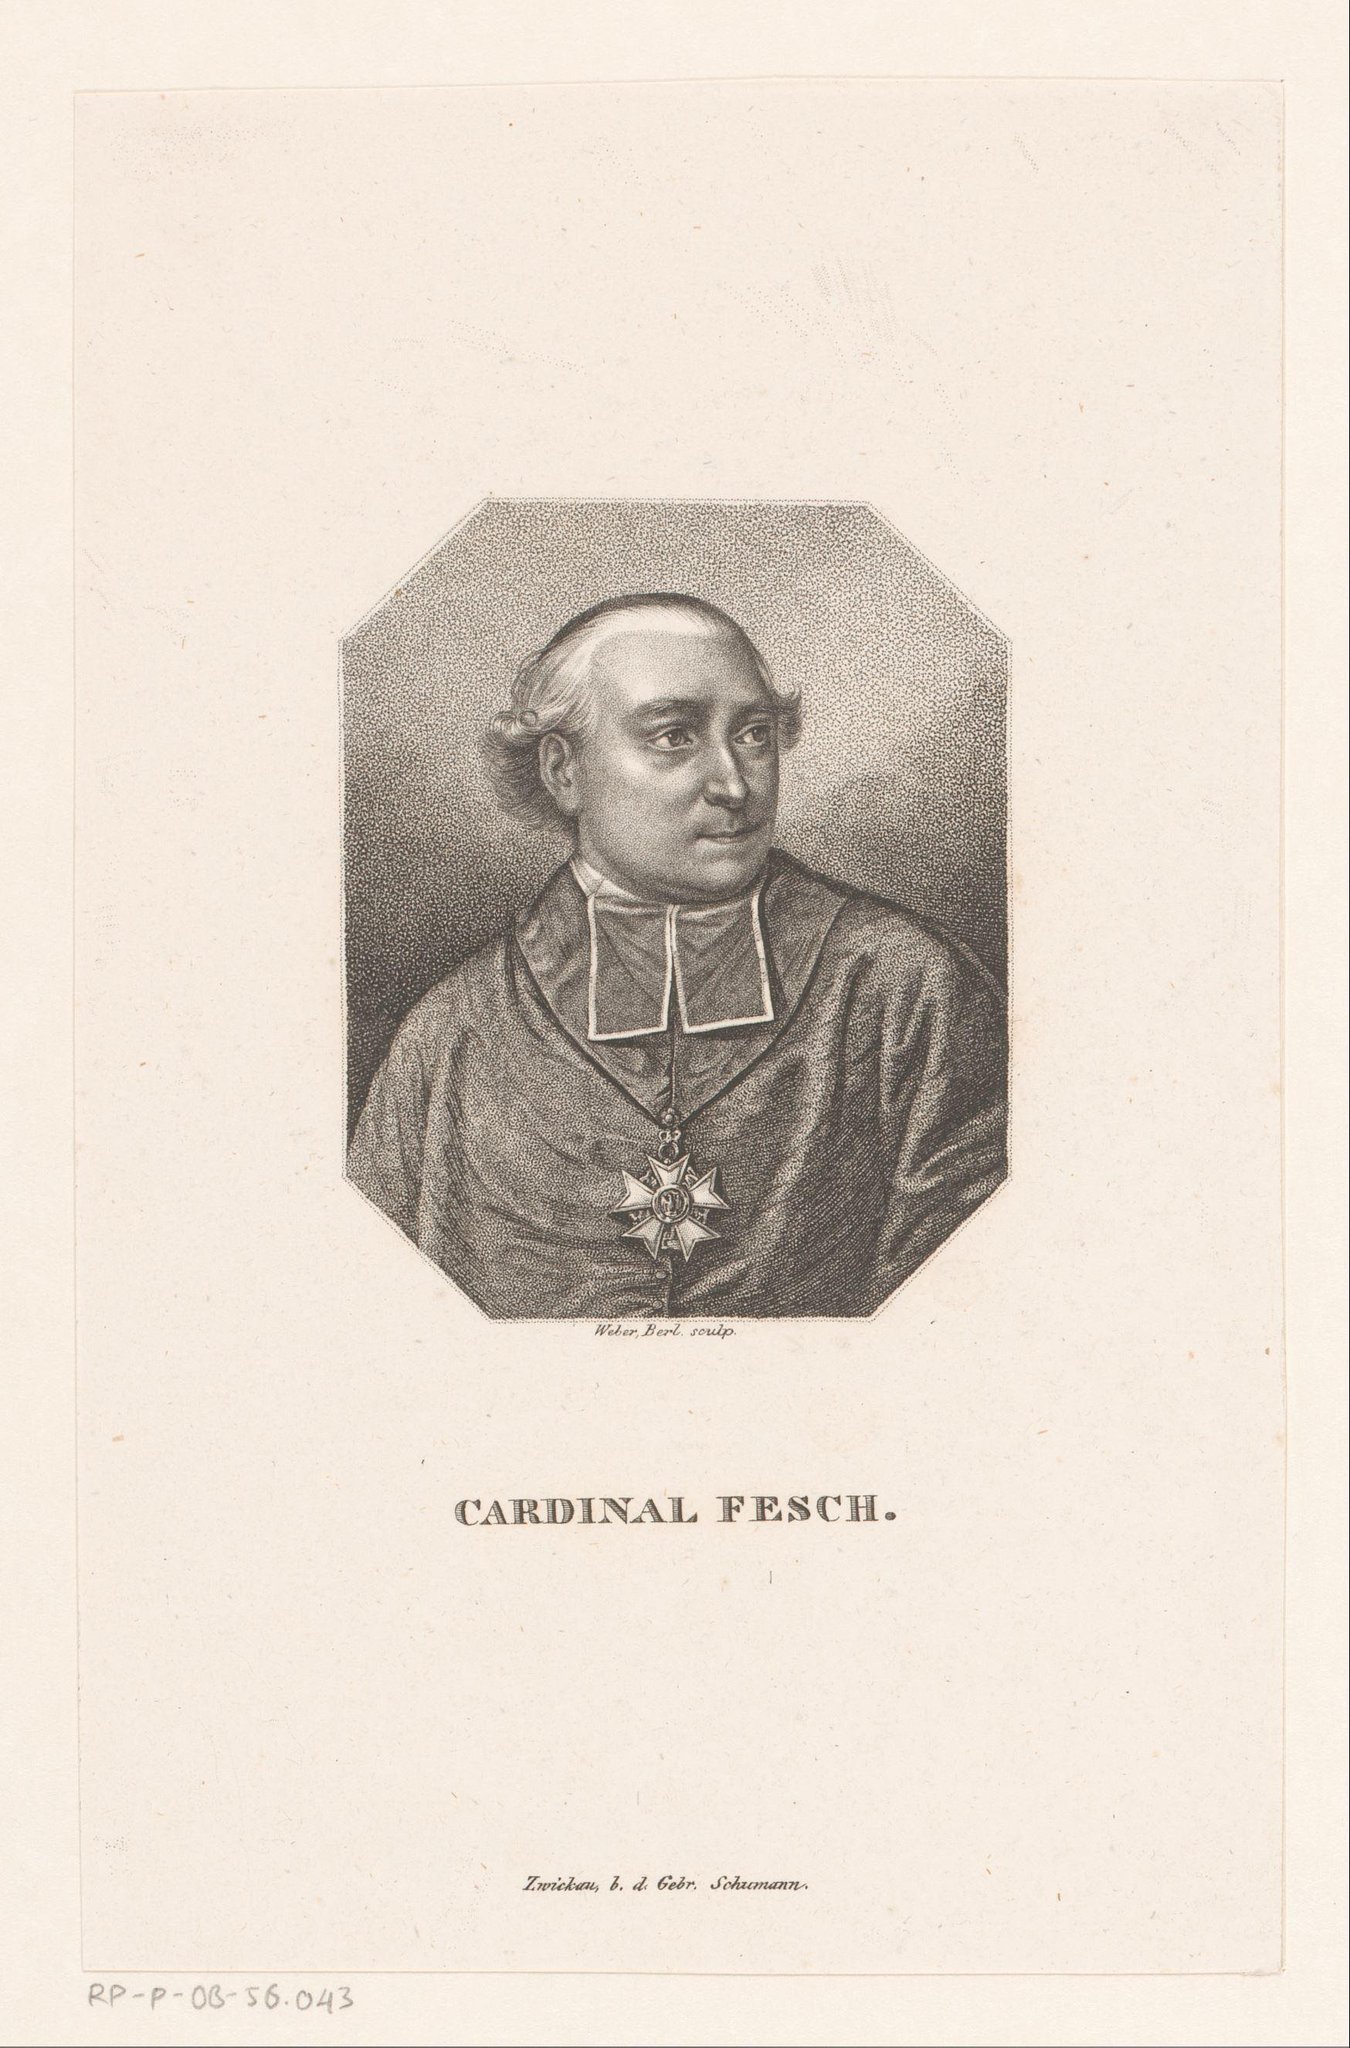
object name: print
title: Portret van kardinaal Joseph Fesch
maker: karl eduard weber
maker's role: draughtsman, painter, print maker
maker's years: 1806-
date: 1816-1832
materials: paper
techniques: stippling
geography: germany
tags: cardinal, historical persons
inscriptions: collector's mark: Lugt 2228